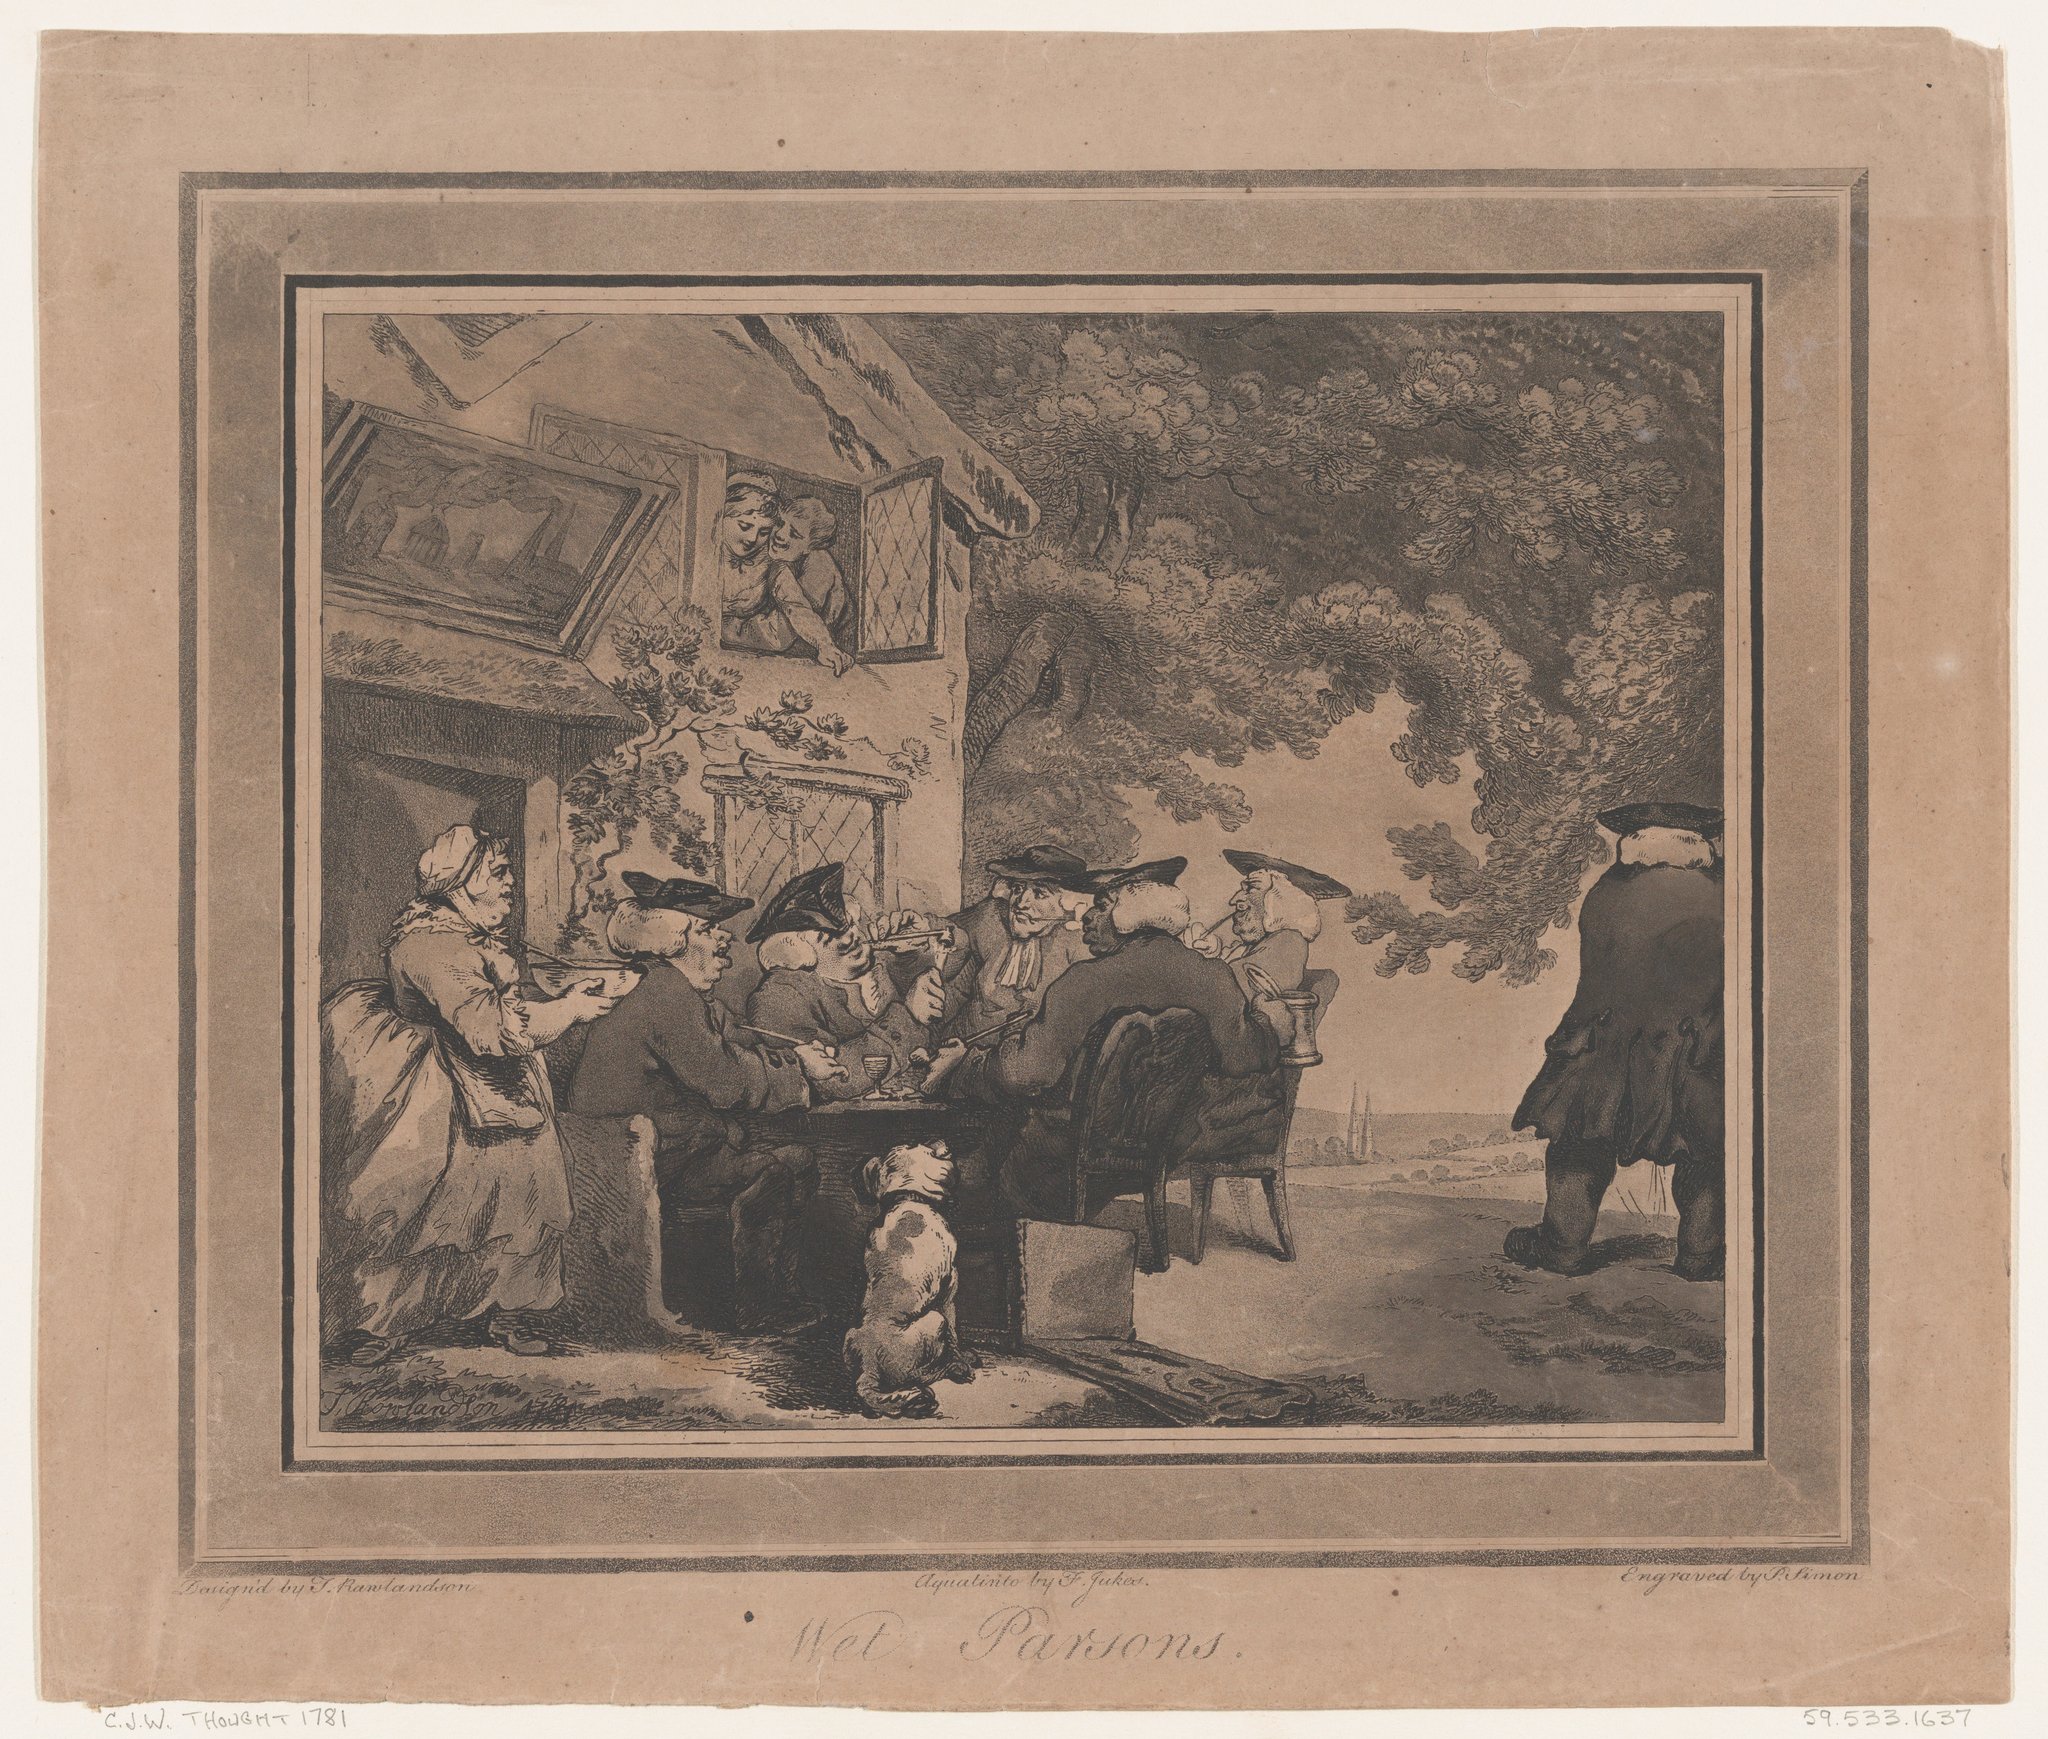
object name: print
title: Wet Parsons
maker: thomas rowlandson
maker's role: artist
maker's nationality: british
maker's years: 1757-1827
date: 1785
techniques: aquatint, etching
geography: london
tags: men,women,smoking,dogs